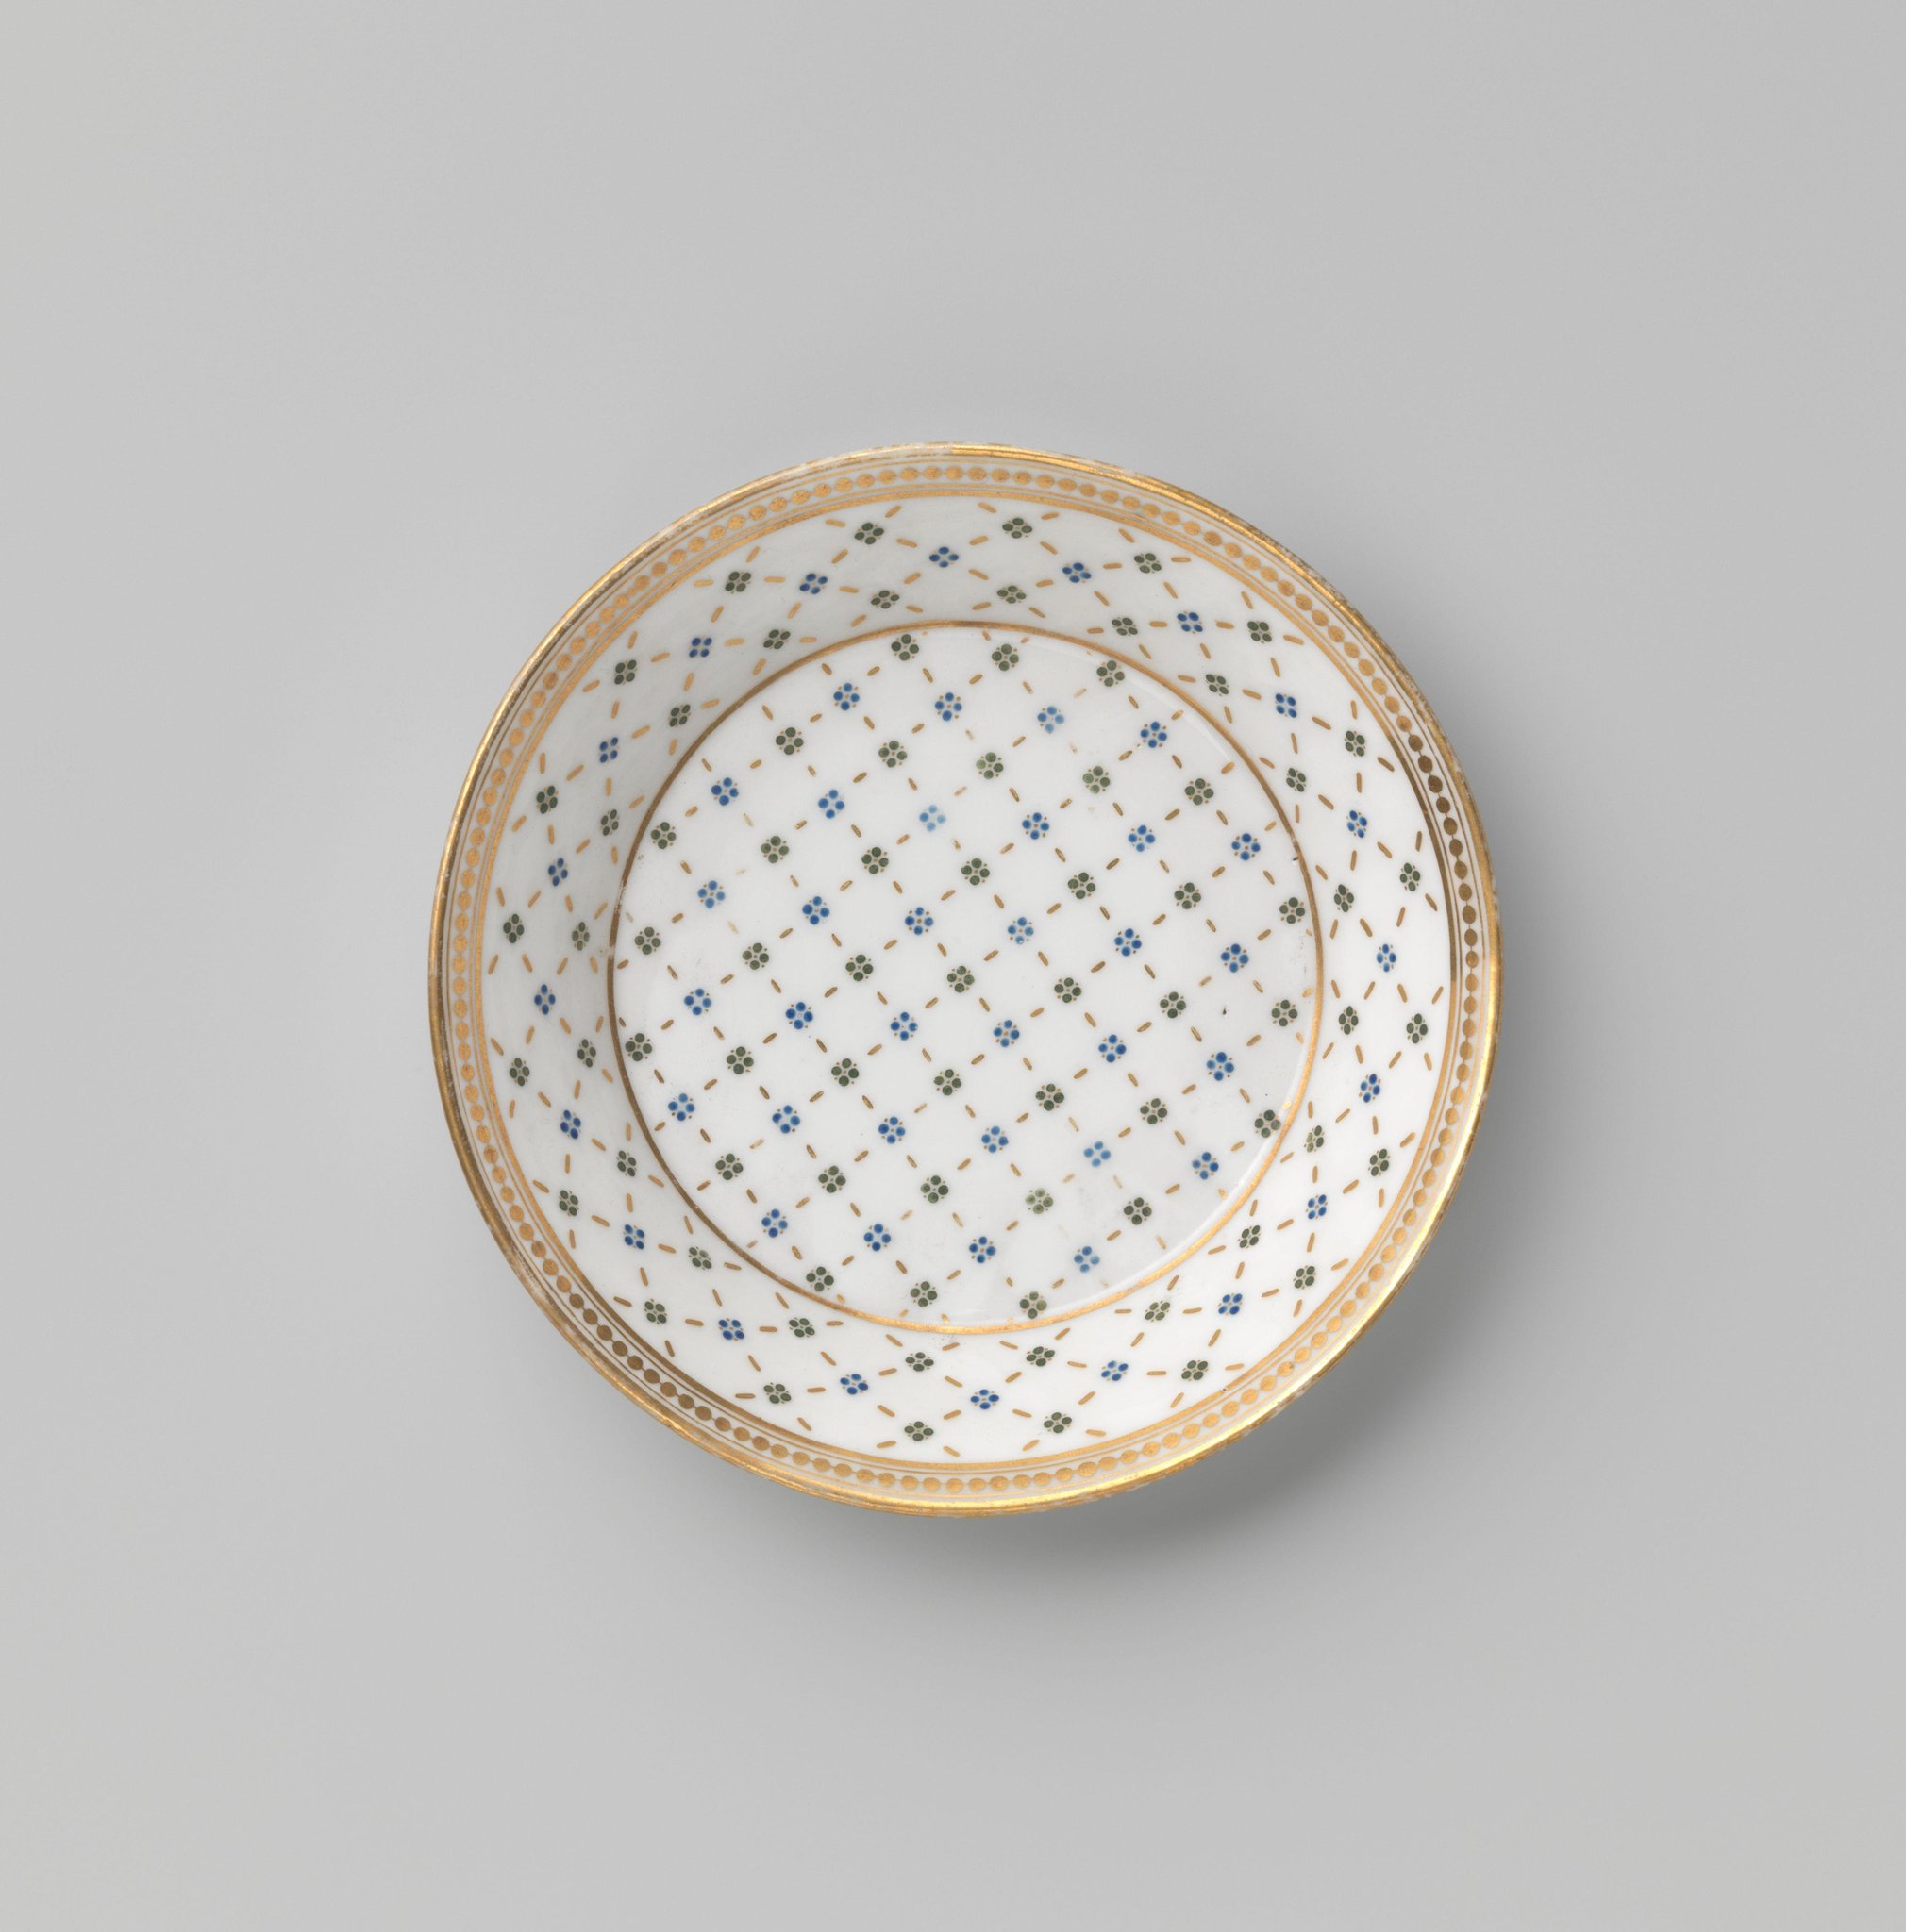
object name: platter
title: Saucer with a lozenge pattern formed by stripes and dots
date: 1775-1790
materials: glaze, gold, paint, porcelain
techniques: firing, gilding, turning, vitrification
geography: clignancourt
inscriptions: mark: ‘LSX’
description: Schotel van porselein met een rechte wand, beschilderd op het glazuur met blauw, groen, goud. Op het plat en de binnenwand een ruitpatroon gevormd door gouden strepen en kleine rozetten van stippen. De binnenrand met een decoratieve band. Gouden rand. Gemerkt op de onderzijde met het monogram 'LSX'.